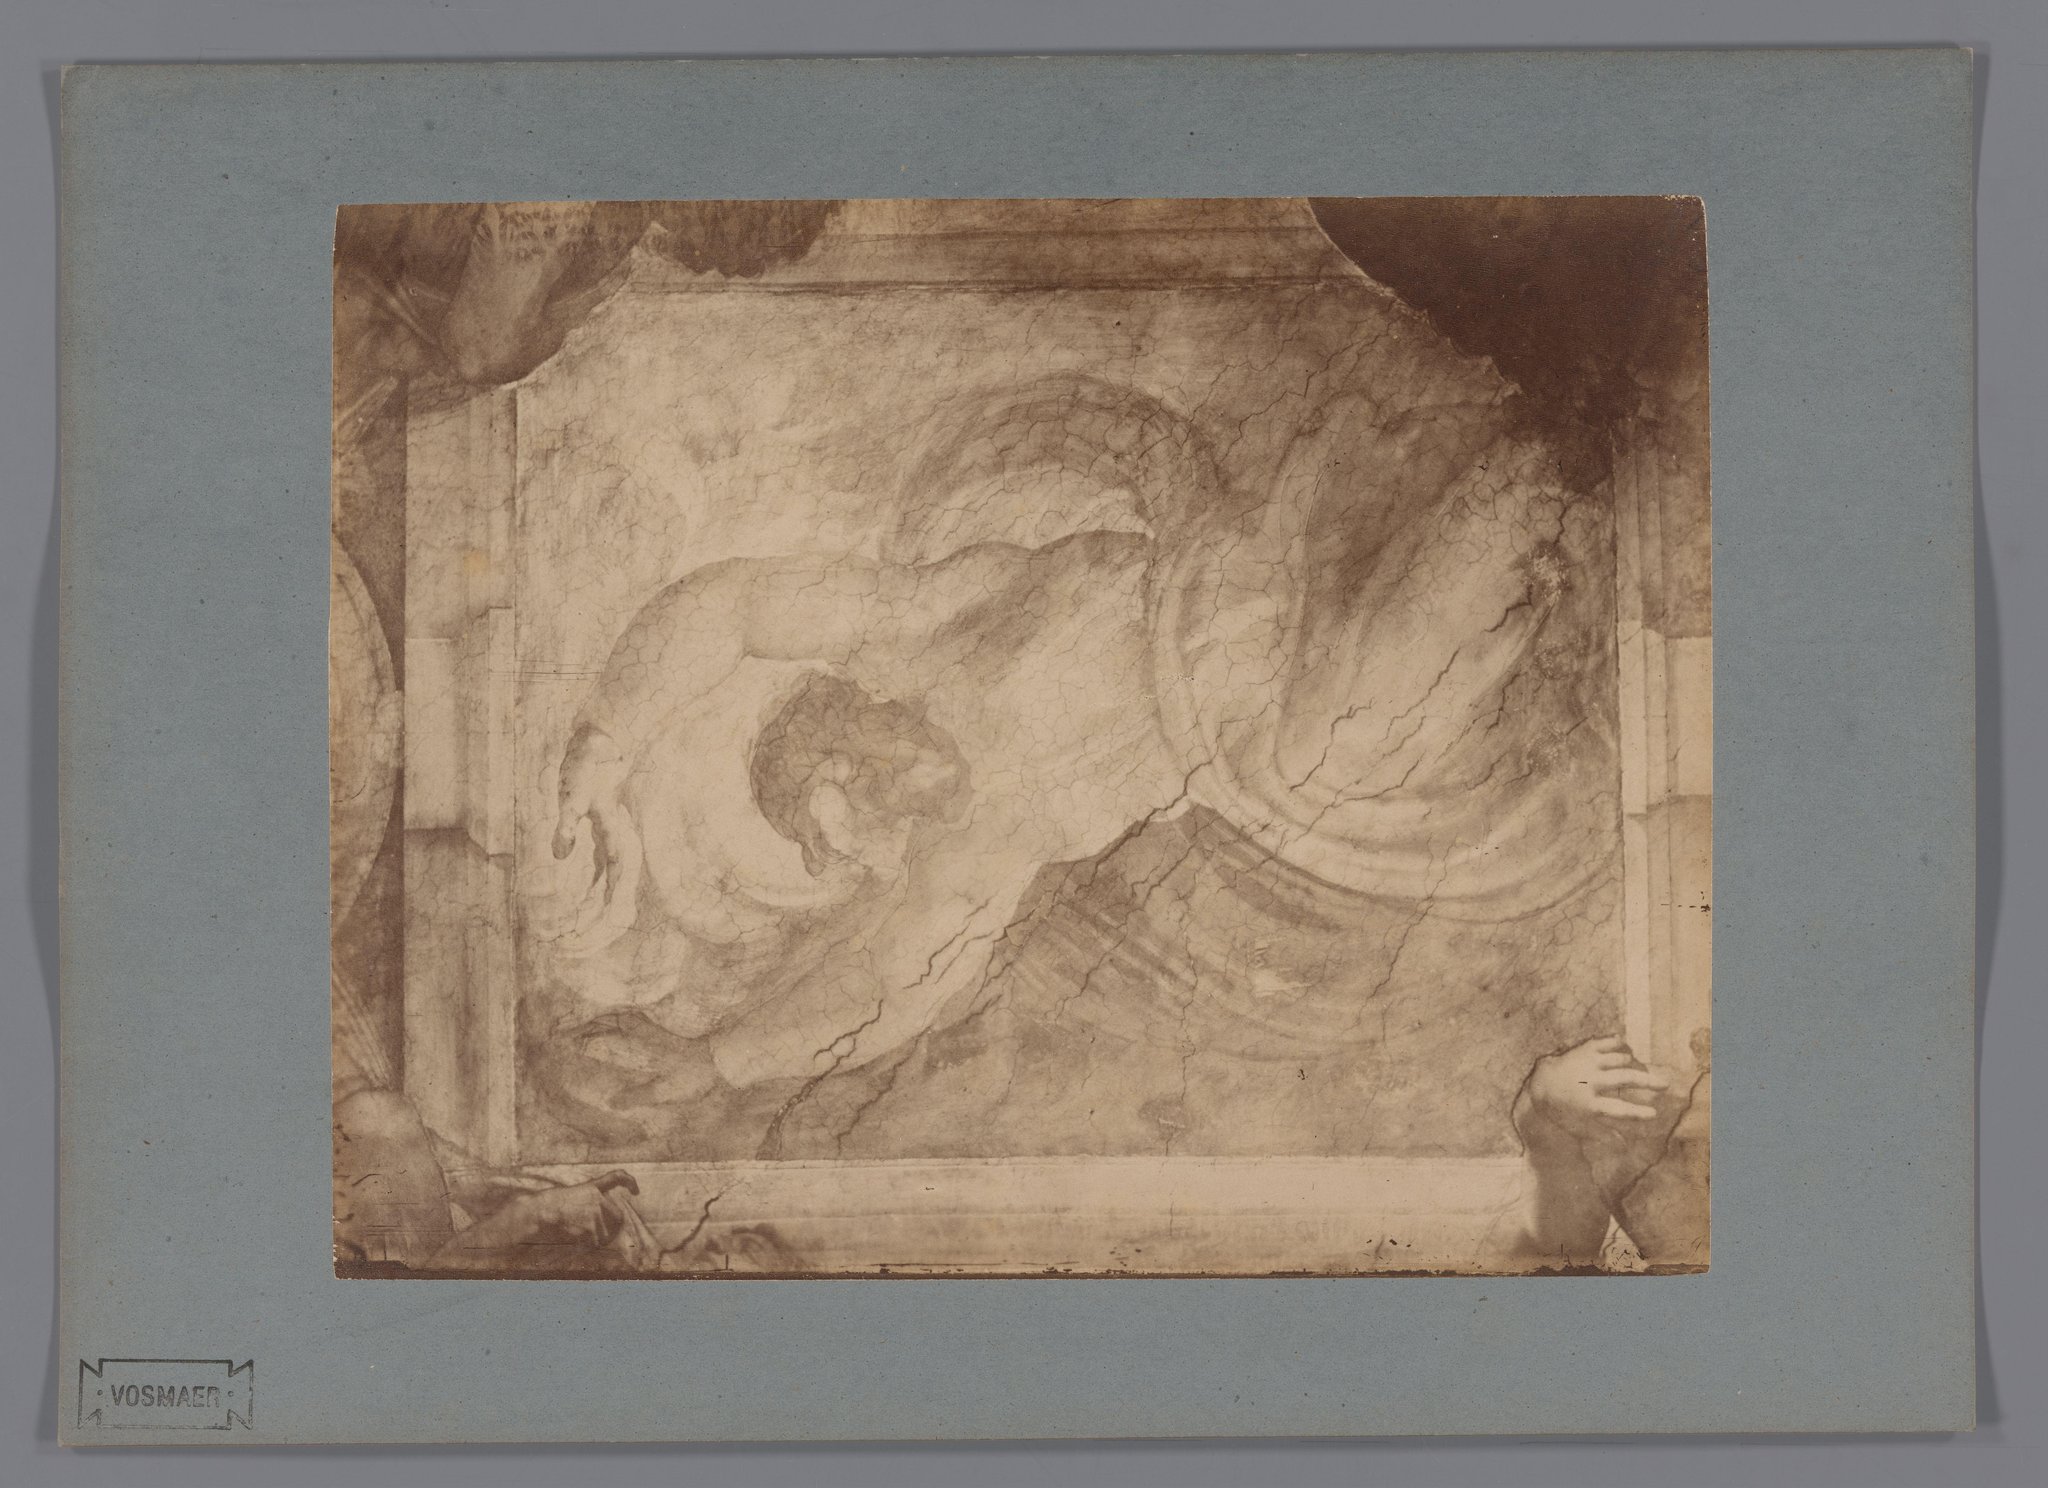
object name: reproduction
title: Fotoreproductie van het fresco De scheiding van donker en licht door Michelangelo in de Sixtijnse kapel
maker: Anonymous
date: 1851-1900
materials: cardboard, paper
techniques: albumen print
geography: vatican city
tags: picture, painting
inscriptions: collector's mark: ‘VOSMAER’